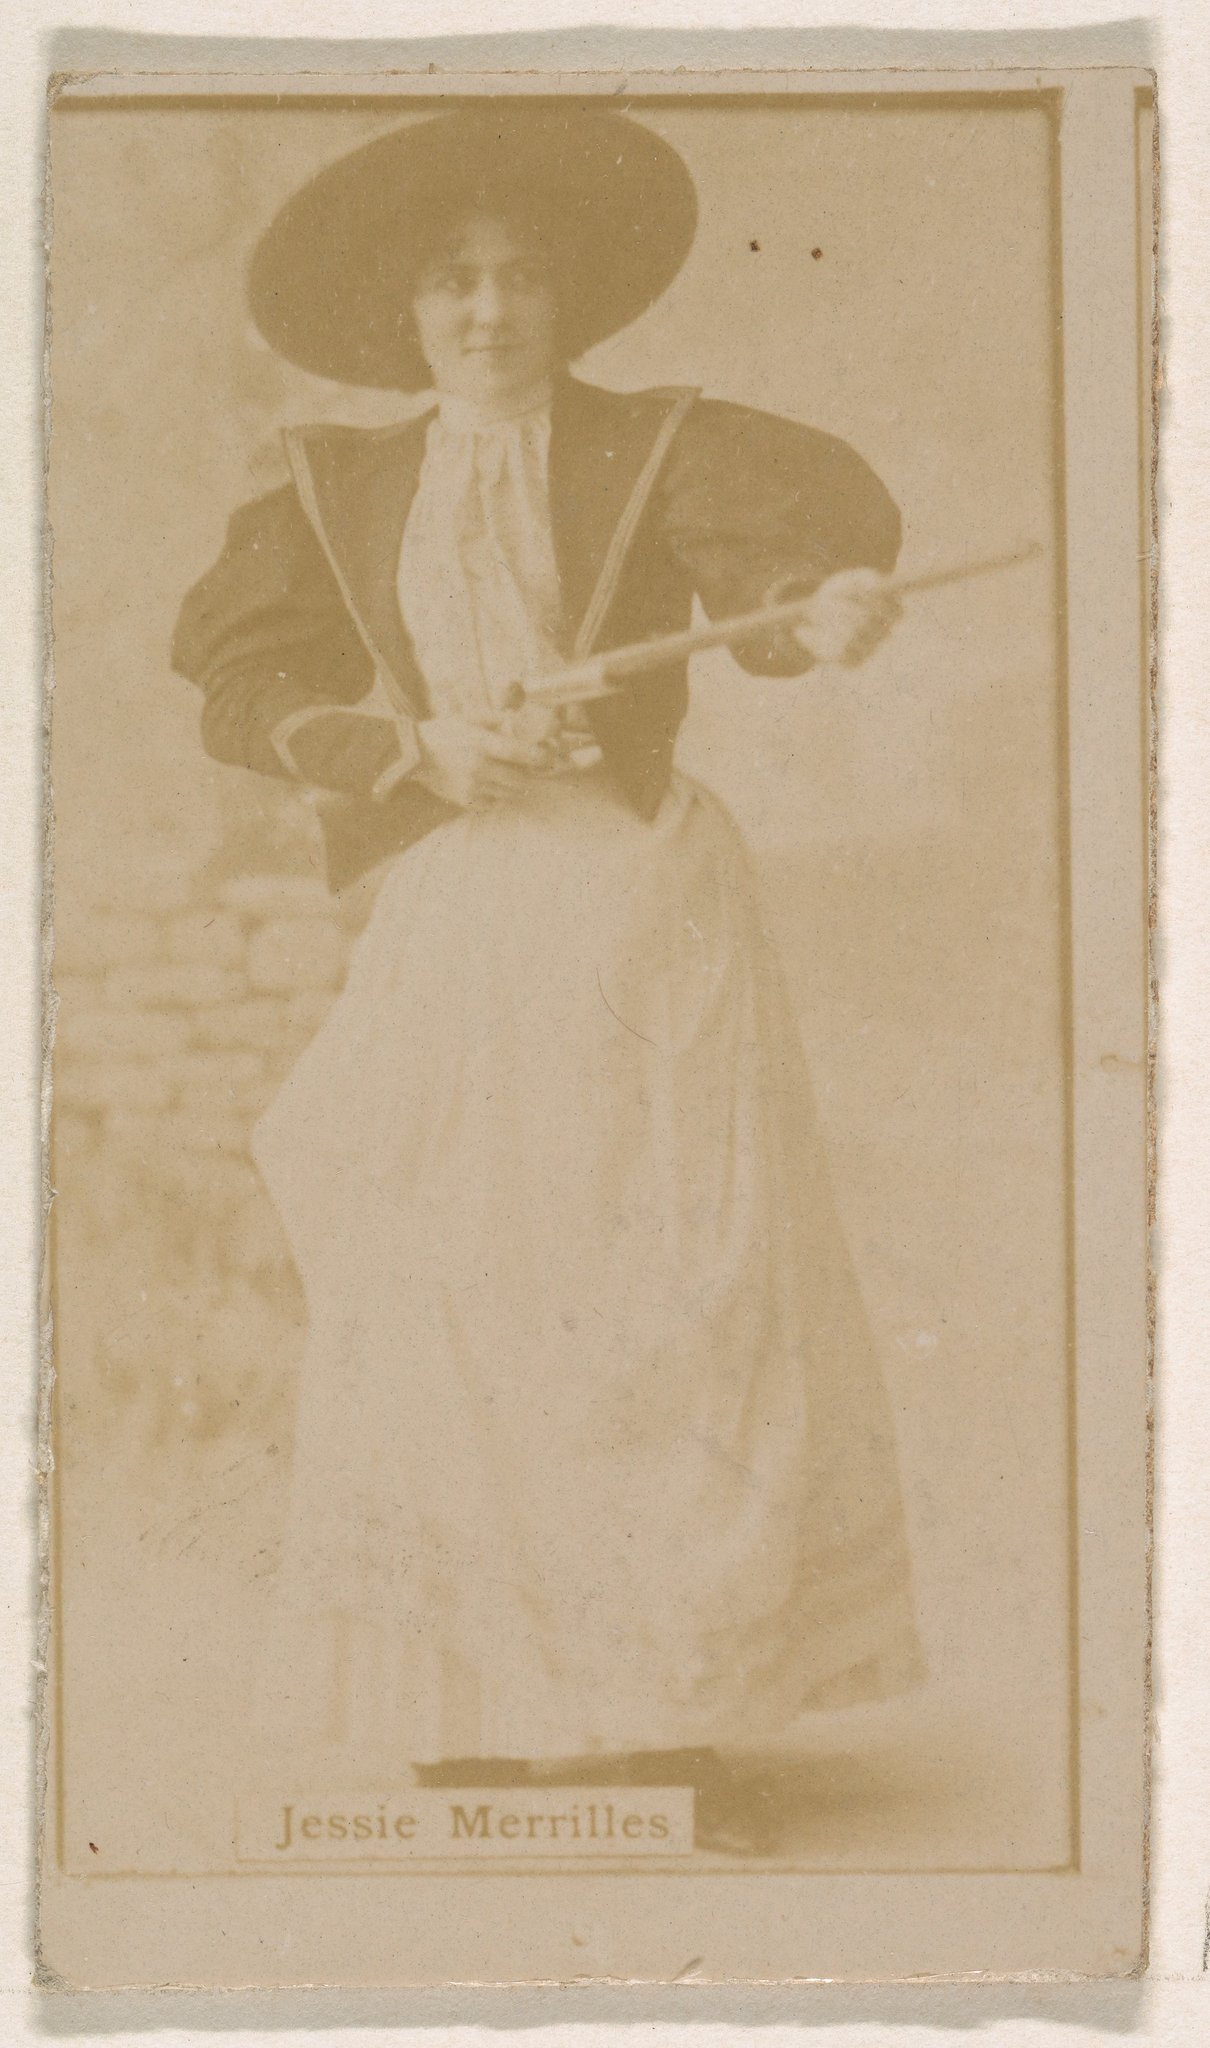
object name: photograph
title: Jessie Merrilles, from the Actresses series (N245) issued by Kinney Brothers to promote Sweet Caporal Cigarettes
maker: kinney brothers tobacco company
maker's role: publisher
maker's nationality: american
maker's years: 1869-2011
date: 1890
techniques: albumen silver print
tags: firearms,portraits,women,actresses